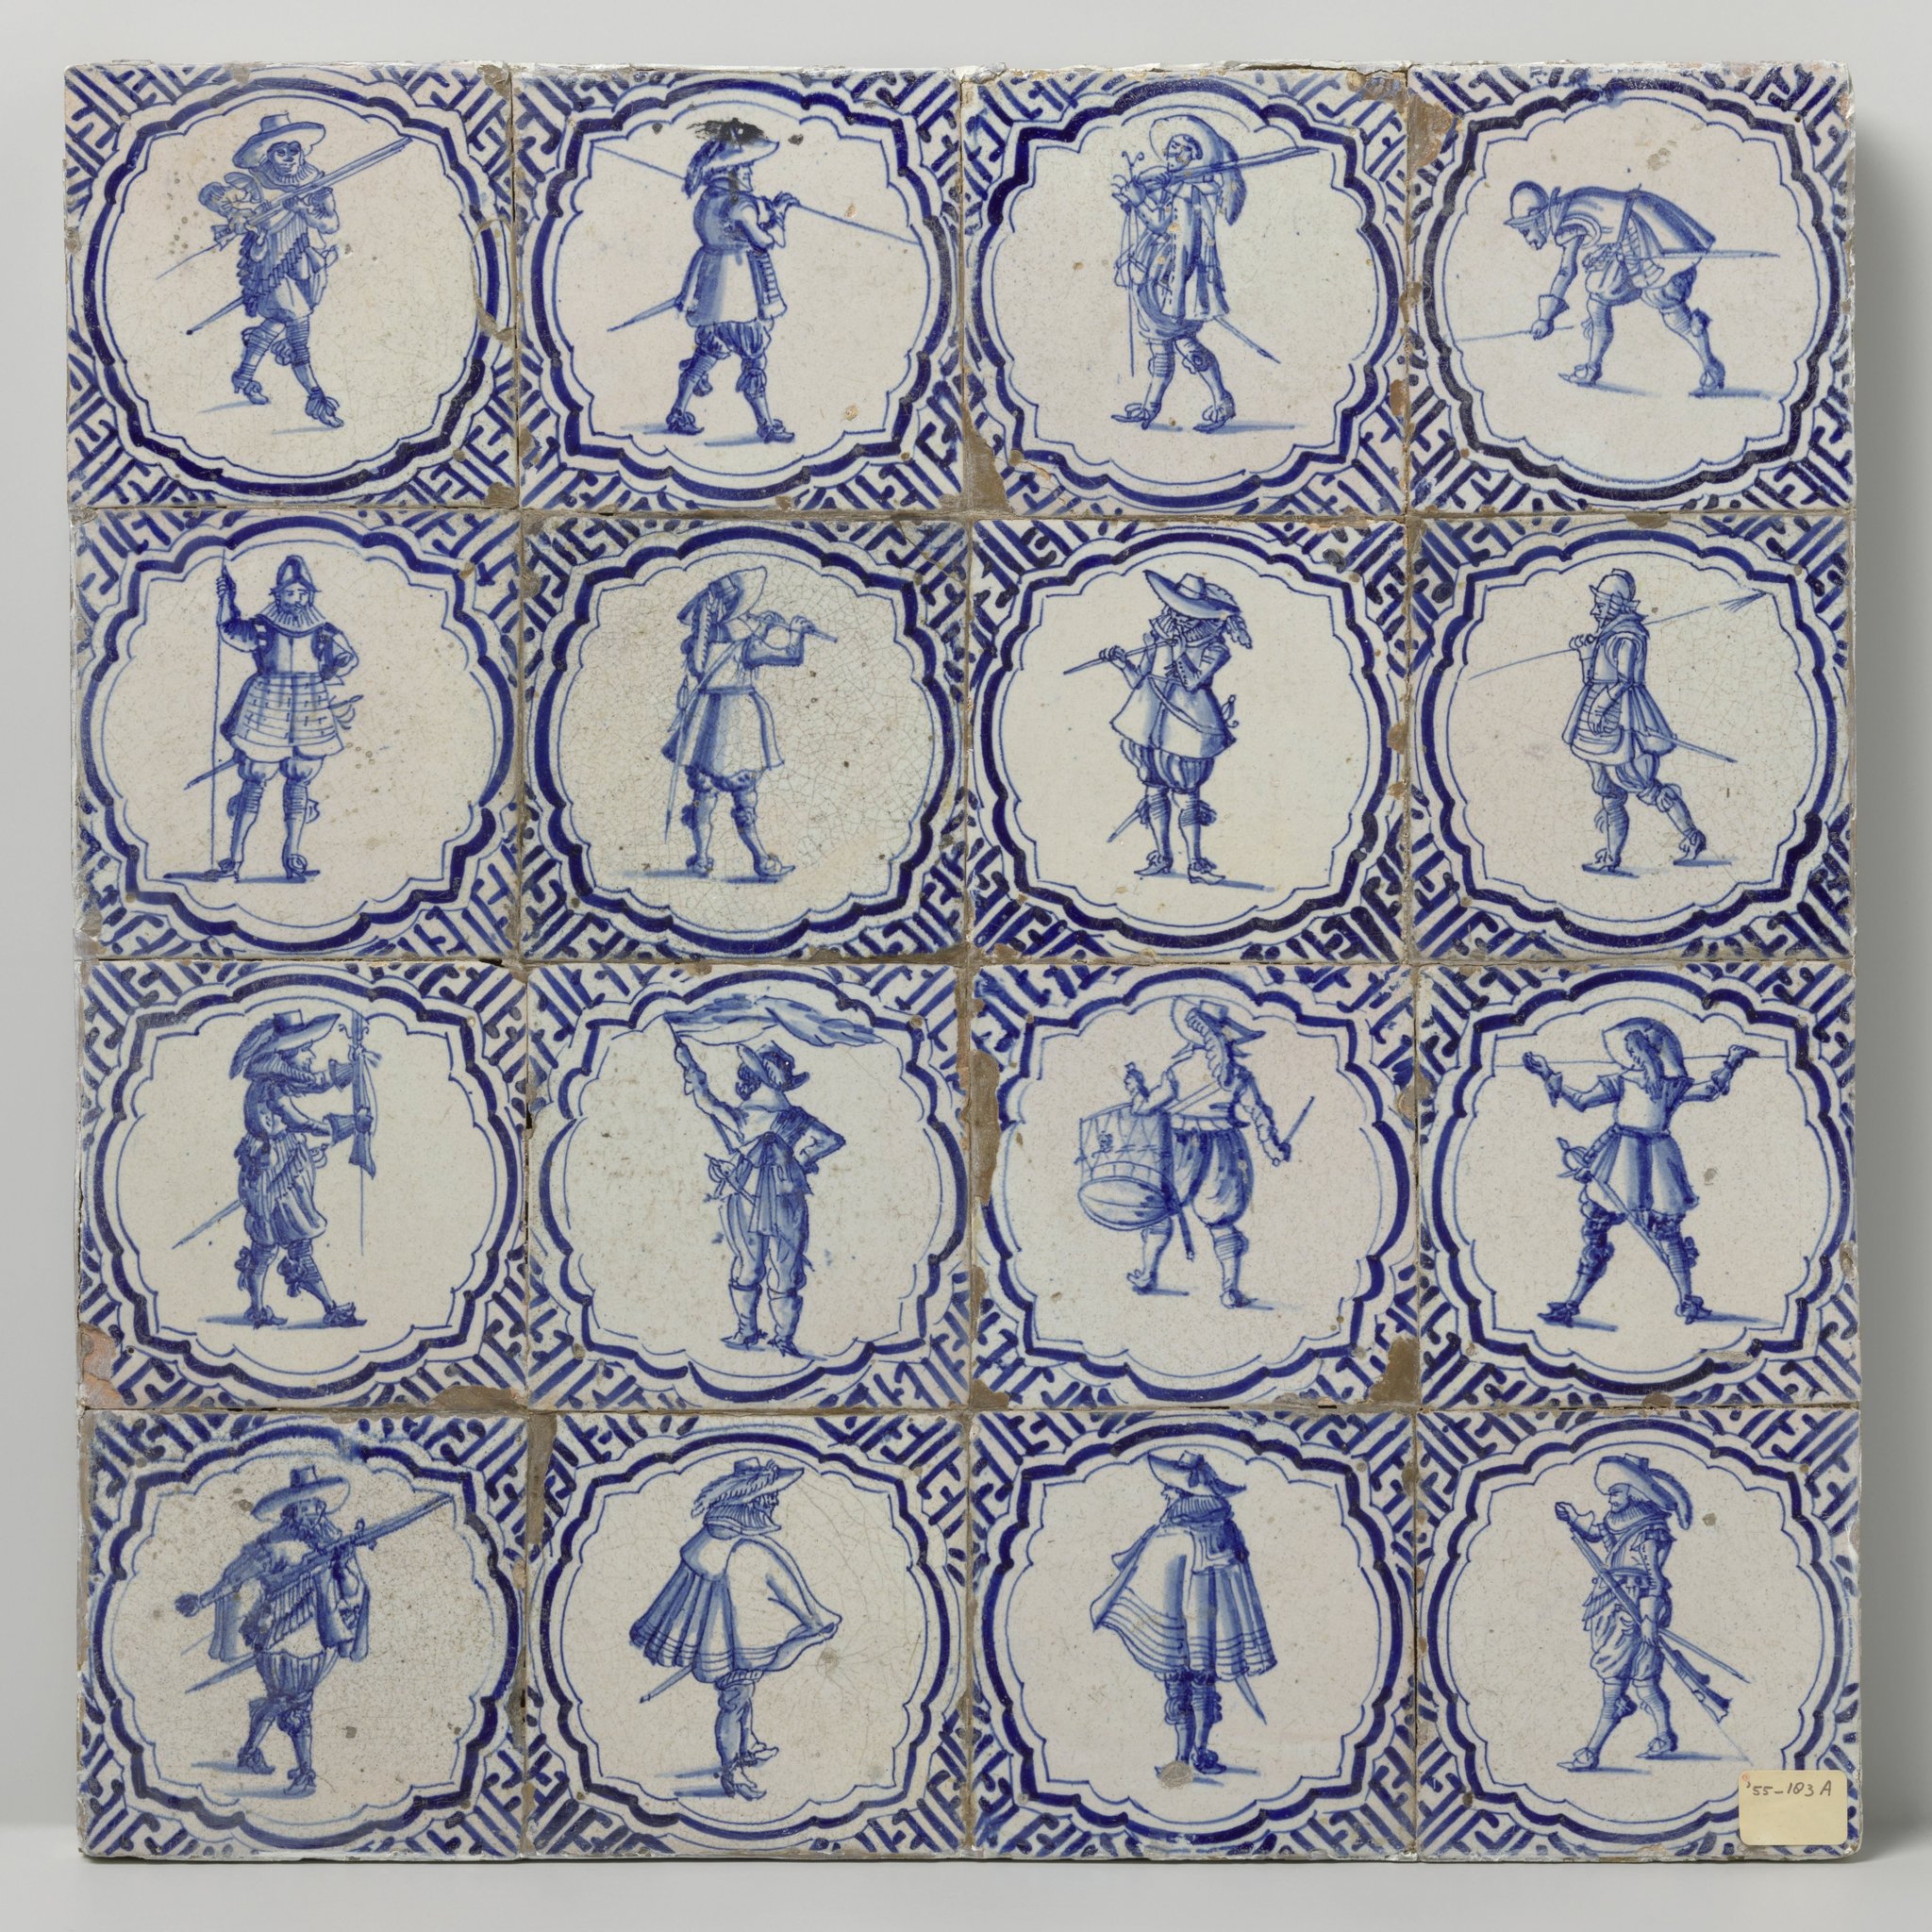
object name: tegelveld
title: Veld van zestien tegels (4x4), elk met een blauw geschilderde krijger, omlijst door een geschulpte rand en meanders in de hoeken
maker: Anonymous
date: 1620-1640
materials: earthenware, glaze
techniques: maiolica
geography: netherlands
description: Veld van zestien tegels (4 x 4) elk met een blauw geschilderde krijger omlijst door een geschulpte rand met in de hoeken een meander.